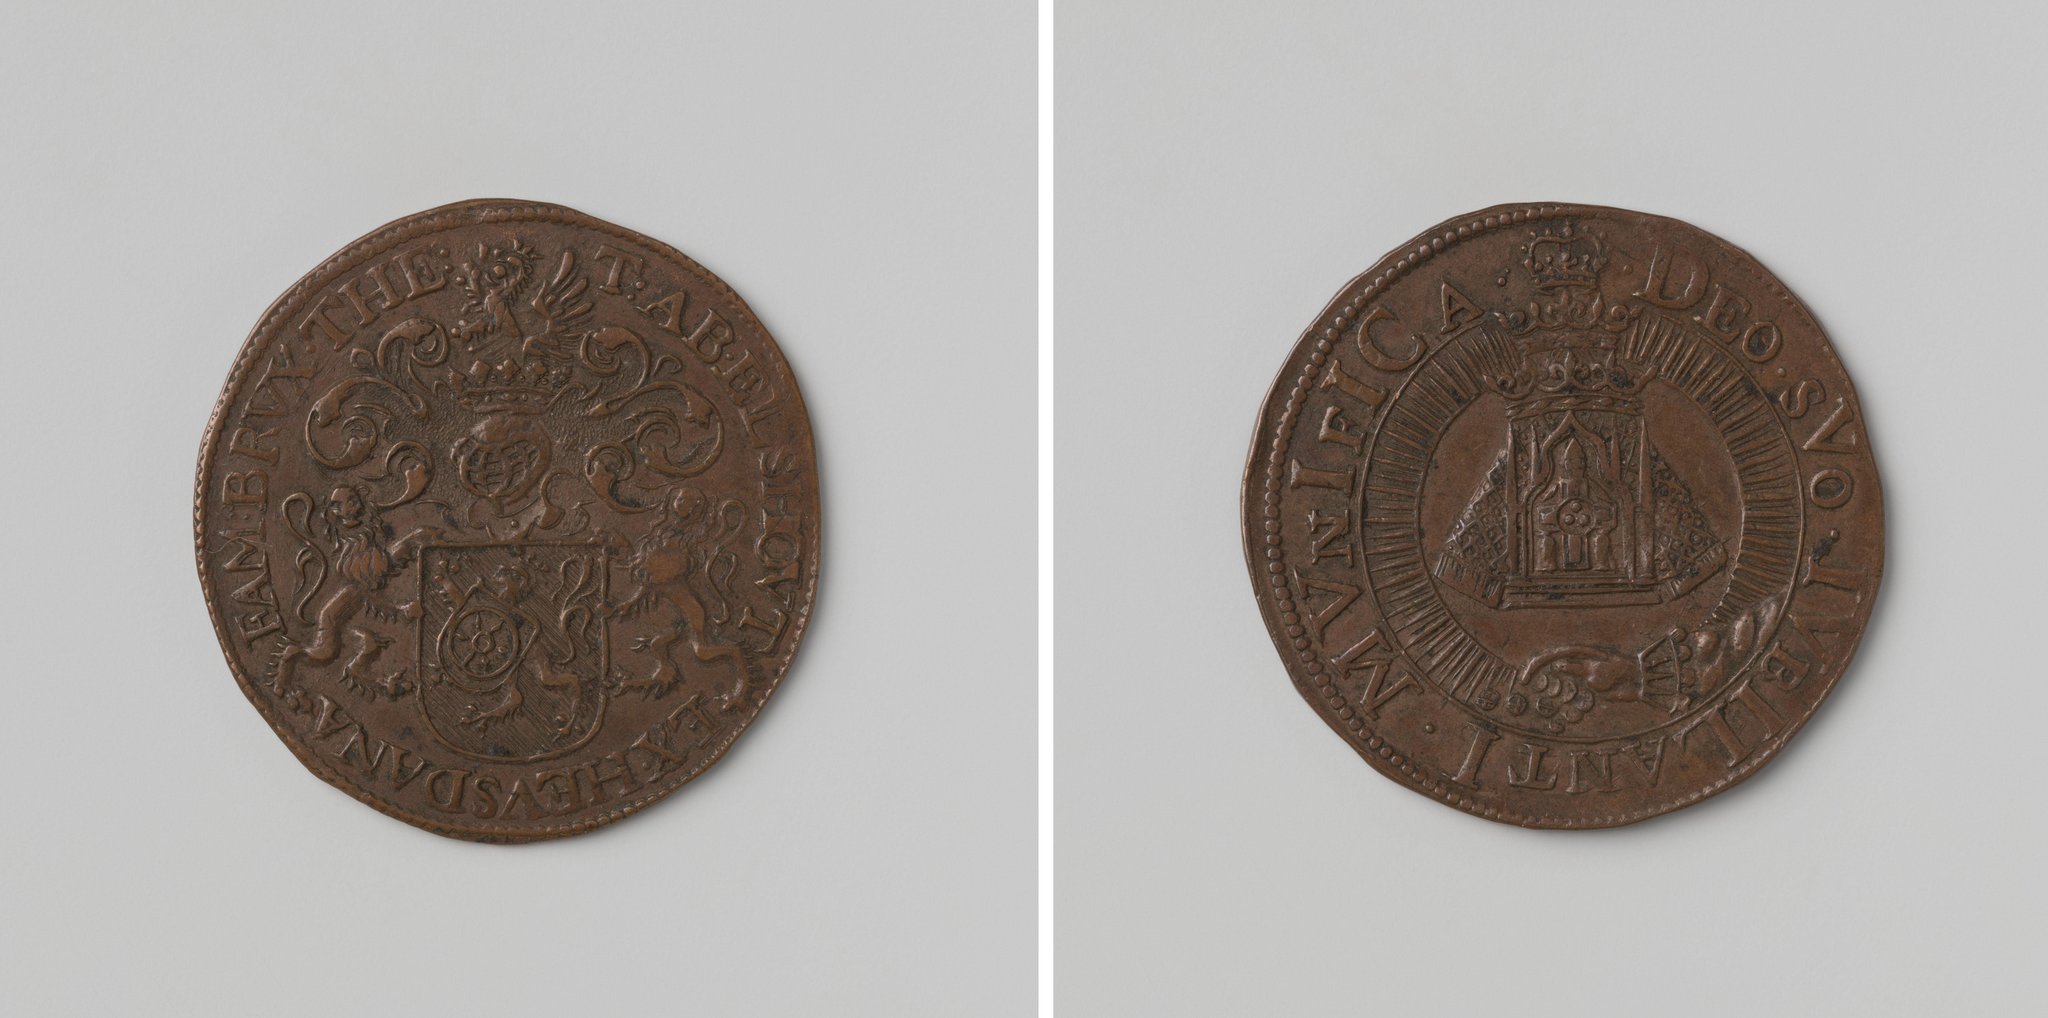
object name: jeton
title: Driehonderdjarige herdenking van het wonder van de mishandelde misbroden te Brussel, rekenpenning van Theodore d'Elshout-Van Heusden, heer van Middelswale, magistraat van de schatkist van Brussel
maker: Anonymous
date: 1601-1670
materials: copper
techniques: striking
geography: brussels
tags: brussels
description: Koperen penning. Voorzijde: met drie kronen gekroond tabernakel waarin drie hosties ten toon gesteld worden; daaronder strooit een hand uit wolken hosties binnen omschrift. Keerzijde: gehelmd wapenschild, geflankeerd door twee leeuwen binnen omschrift